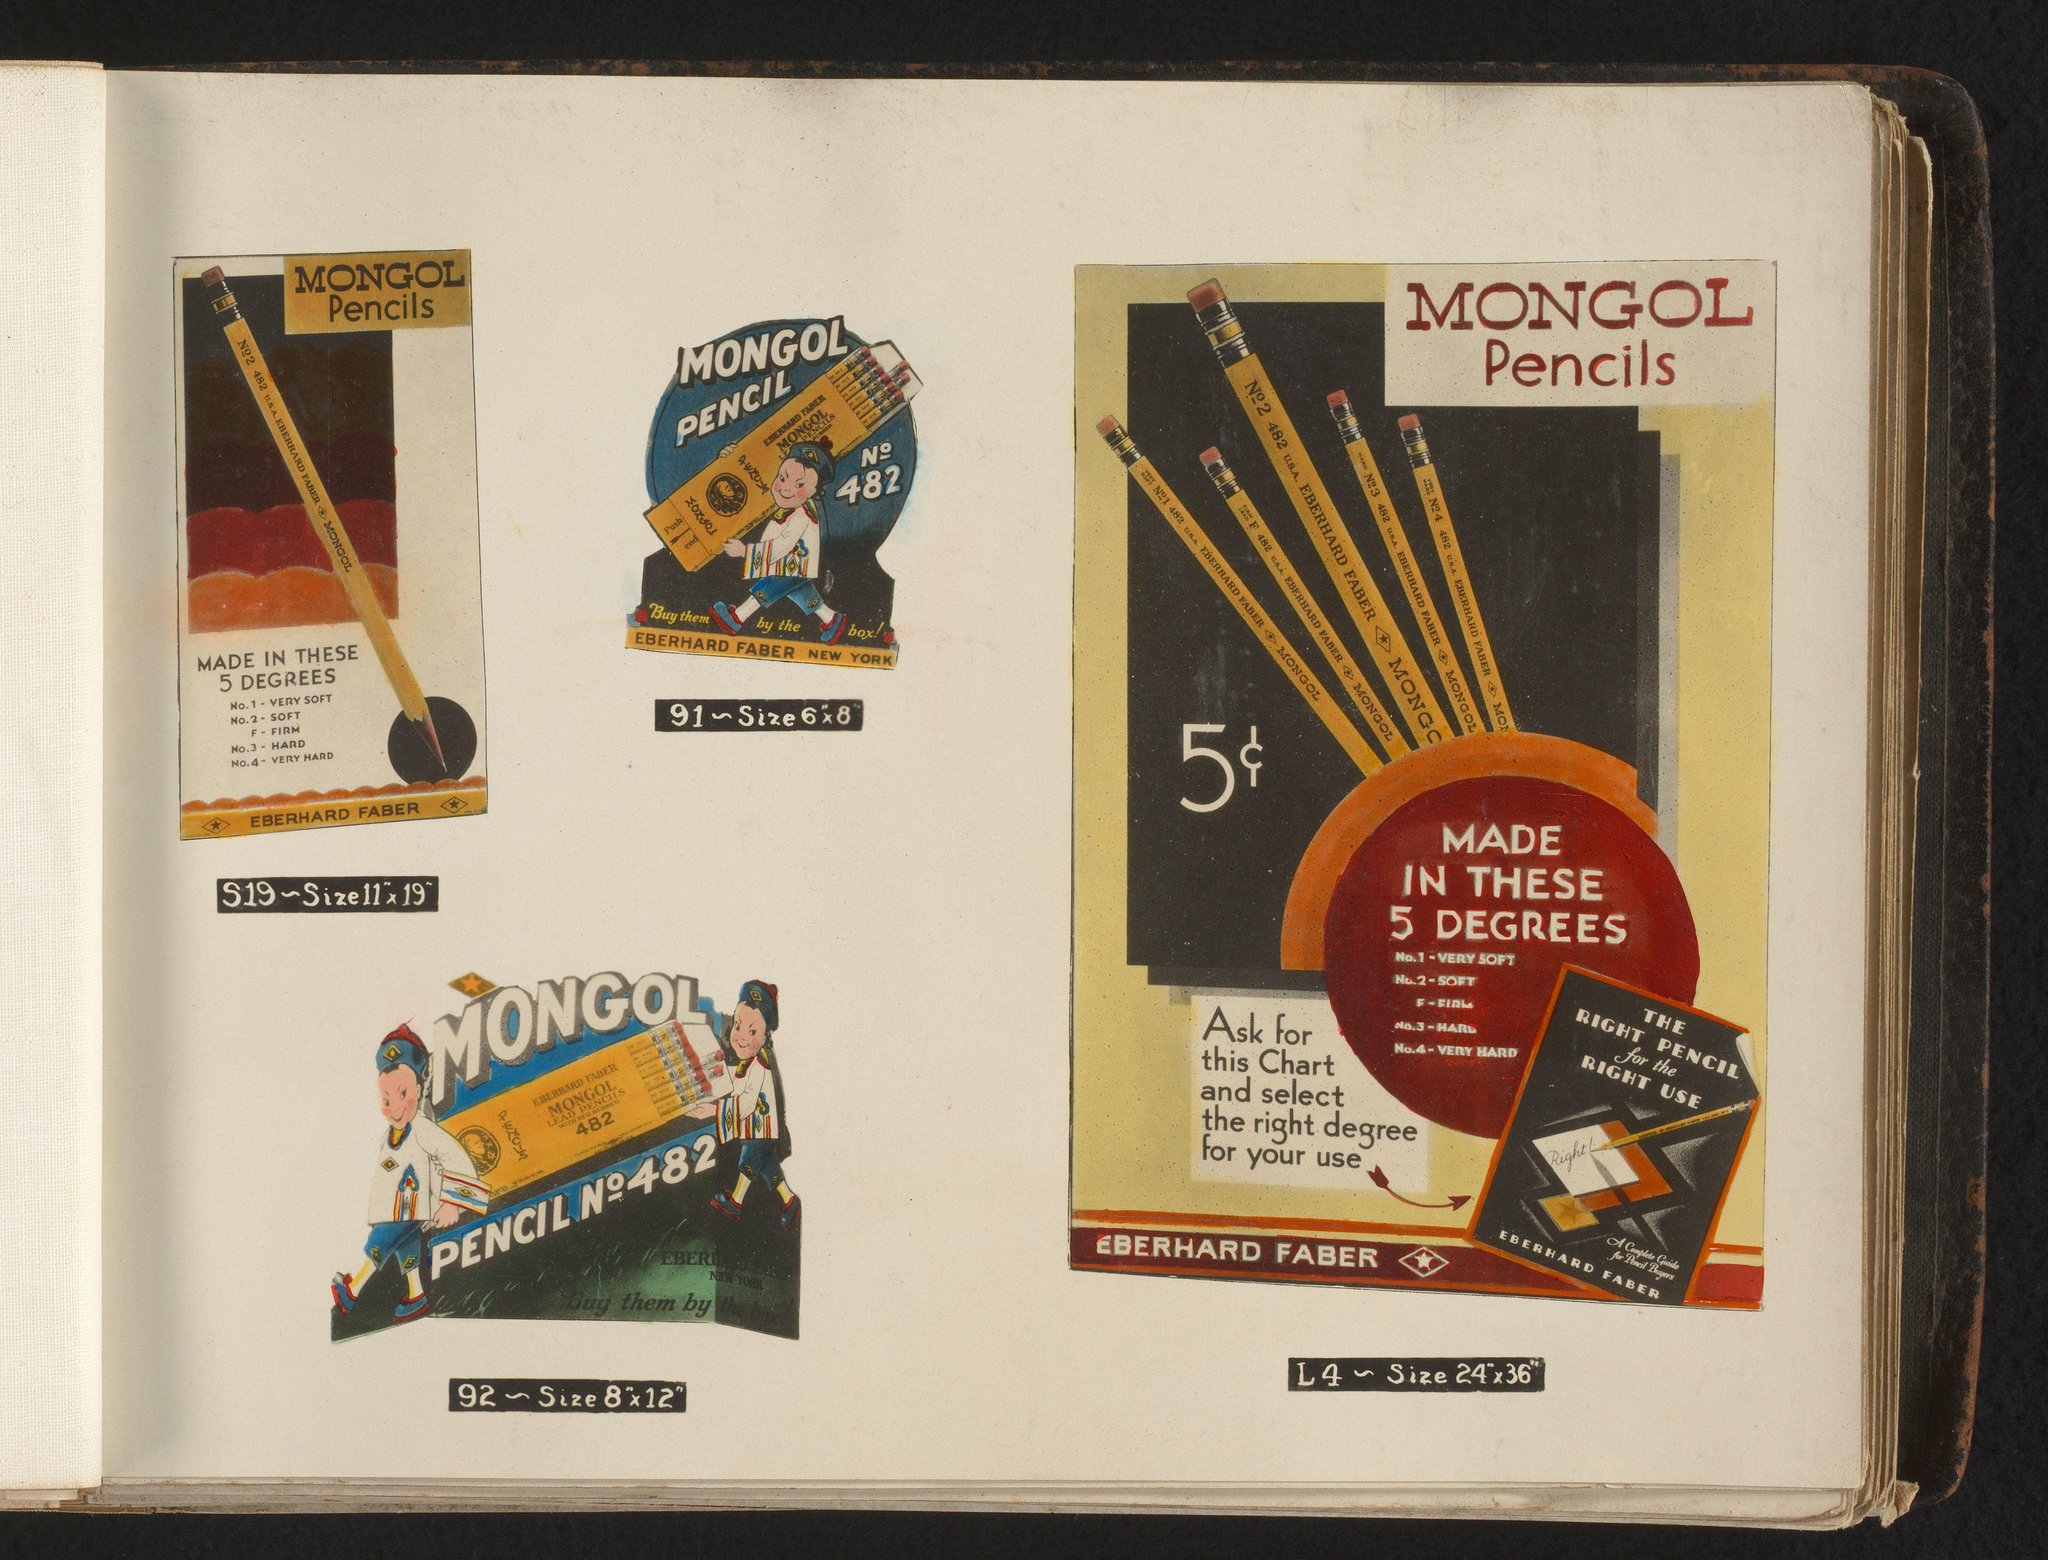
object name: photograph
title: Reclame voor potloden van Eberhard Faber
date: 1915-1935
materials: paper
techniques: gelatin silver print, hand coloring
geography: springfield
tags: pencil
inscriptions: stamp: ‘Paramount/ Commercial Studios/ 145 Chestnut St./ Springfield - Mass.’